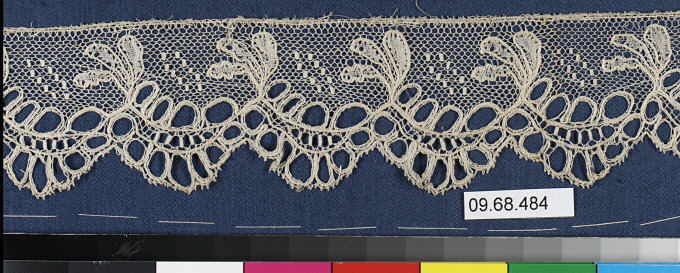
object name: fragment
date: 1801-1900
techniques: lace